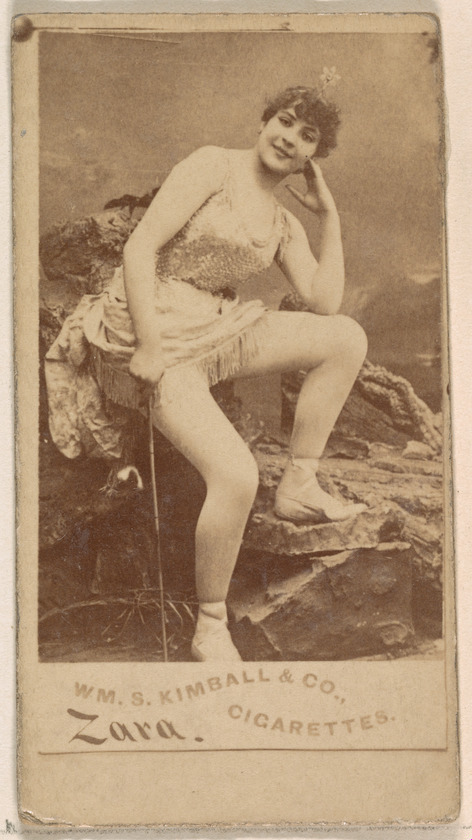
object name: photograph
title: Miss Zara, from the Actresses series (N203) issued by Wm. S. Kimball & Co.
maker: william s. kimball & company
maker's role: publisher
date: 1889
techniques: color lithograph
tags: portraits,women,actresses